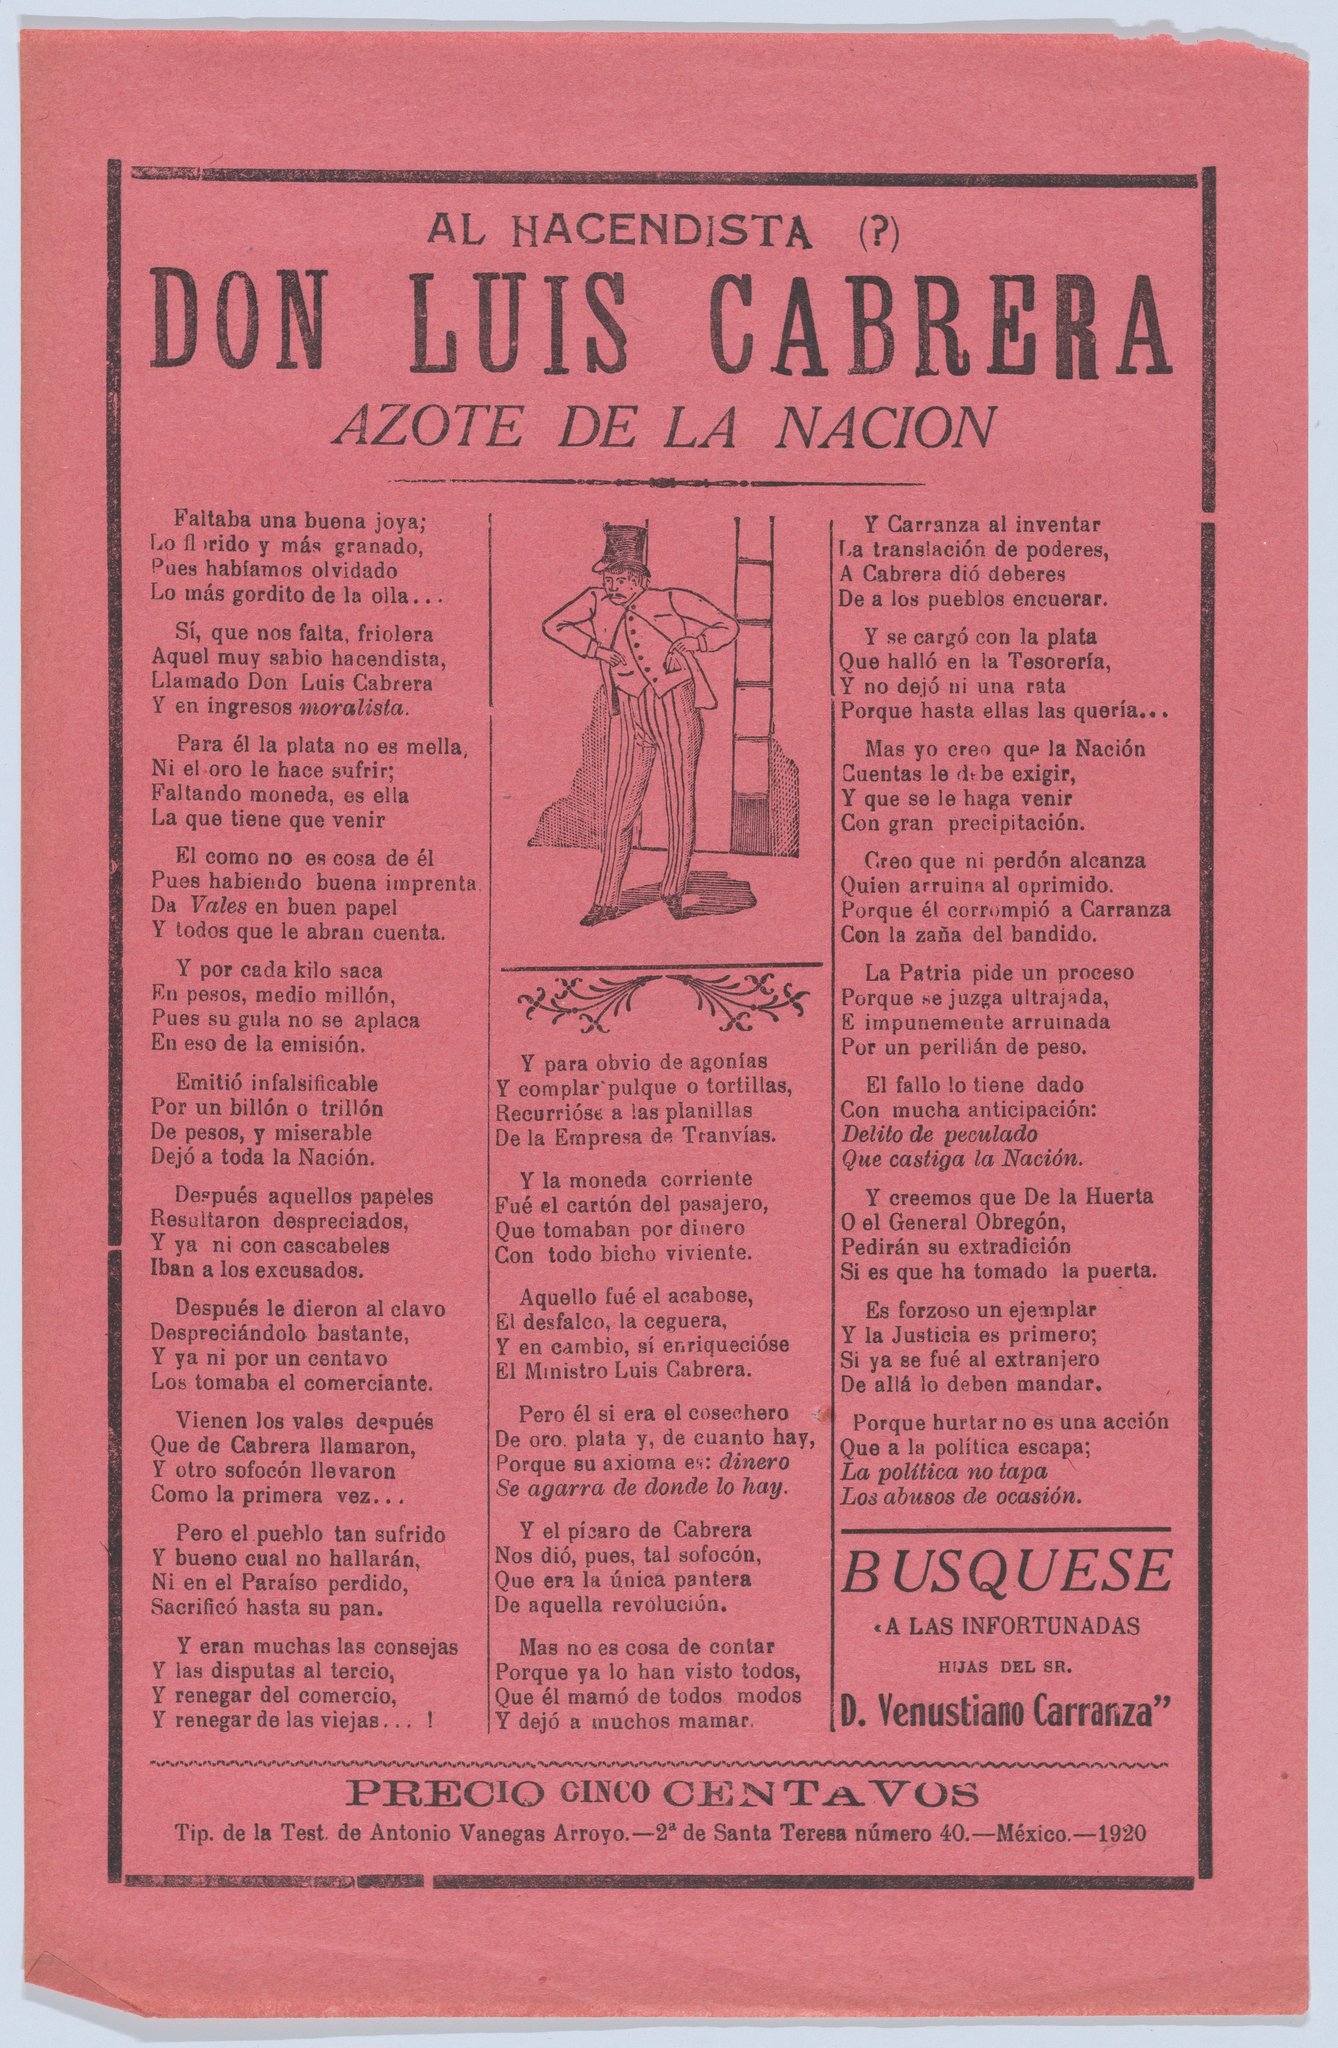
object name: print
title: Broadsheet with verse relating to Don Luis Cabrera ('scourge of the nation') who is shown standing in the center wearing a top hat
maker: manuel manilla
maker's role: artist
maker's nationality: mexican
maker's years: 1830-1895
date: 1920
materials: paper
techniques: letterpress, relief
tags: men